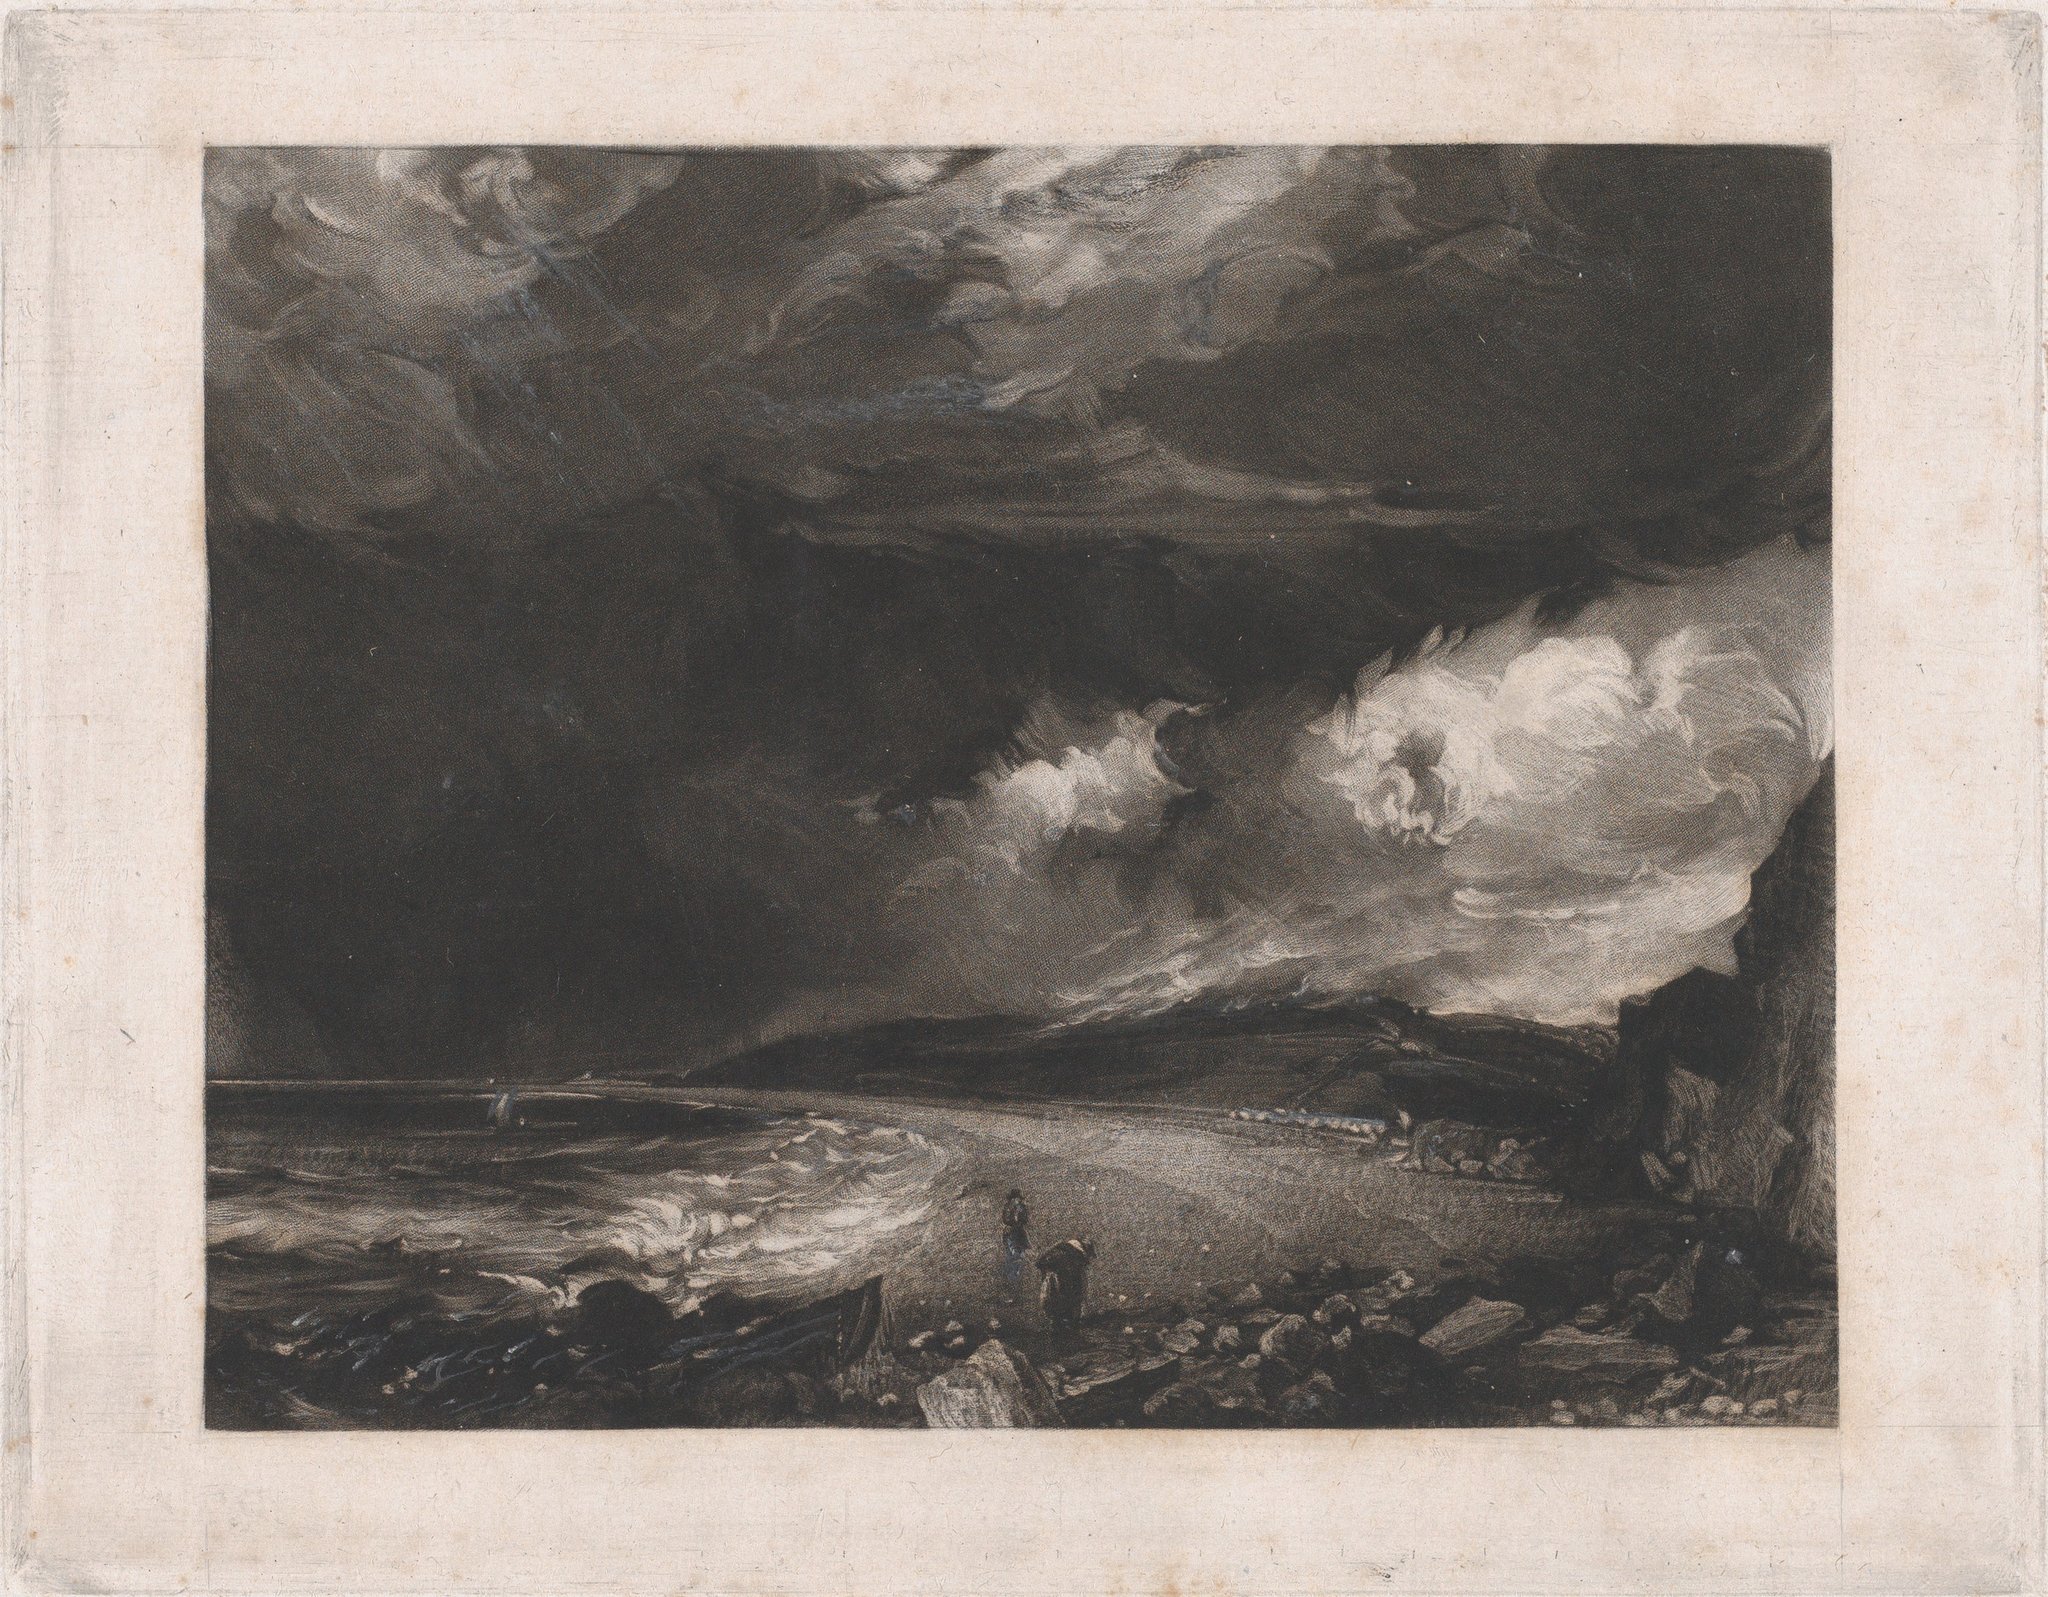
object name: print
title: Weymouth Bay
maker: david lucas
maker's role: artist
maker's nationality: british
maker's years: 1802-1881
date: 1830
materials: chalk, graphite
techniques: mezzotint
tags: landscapes